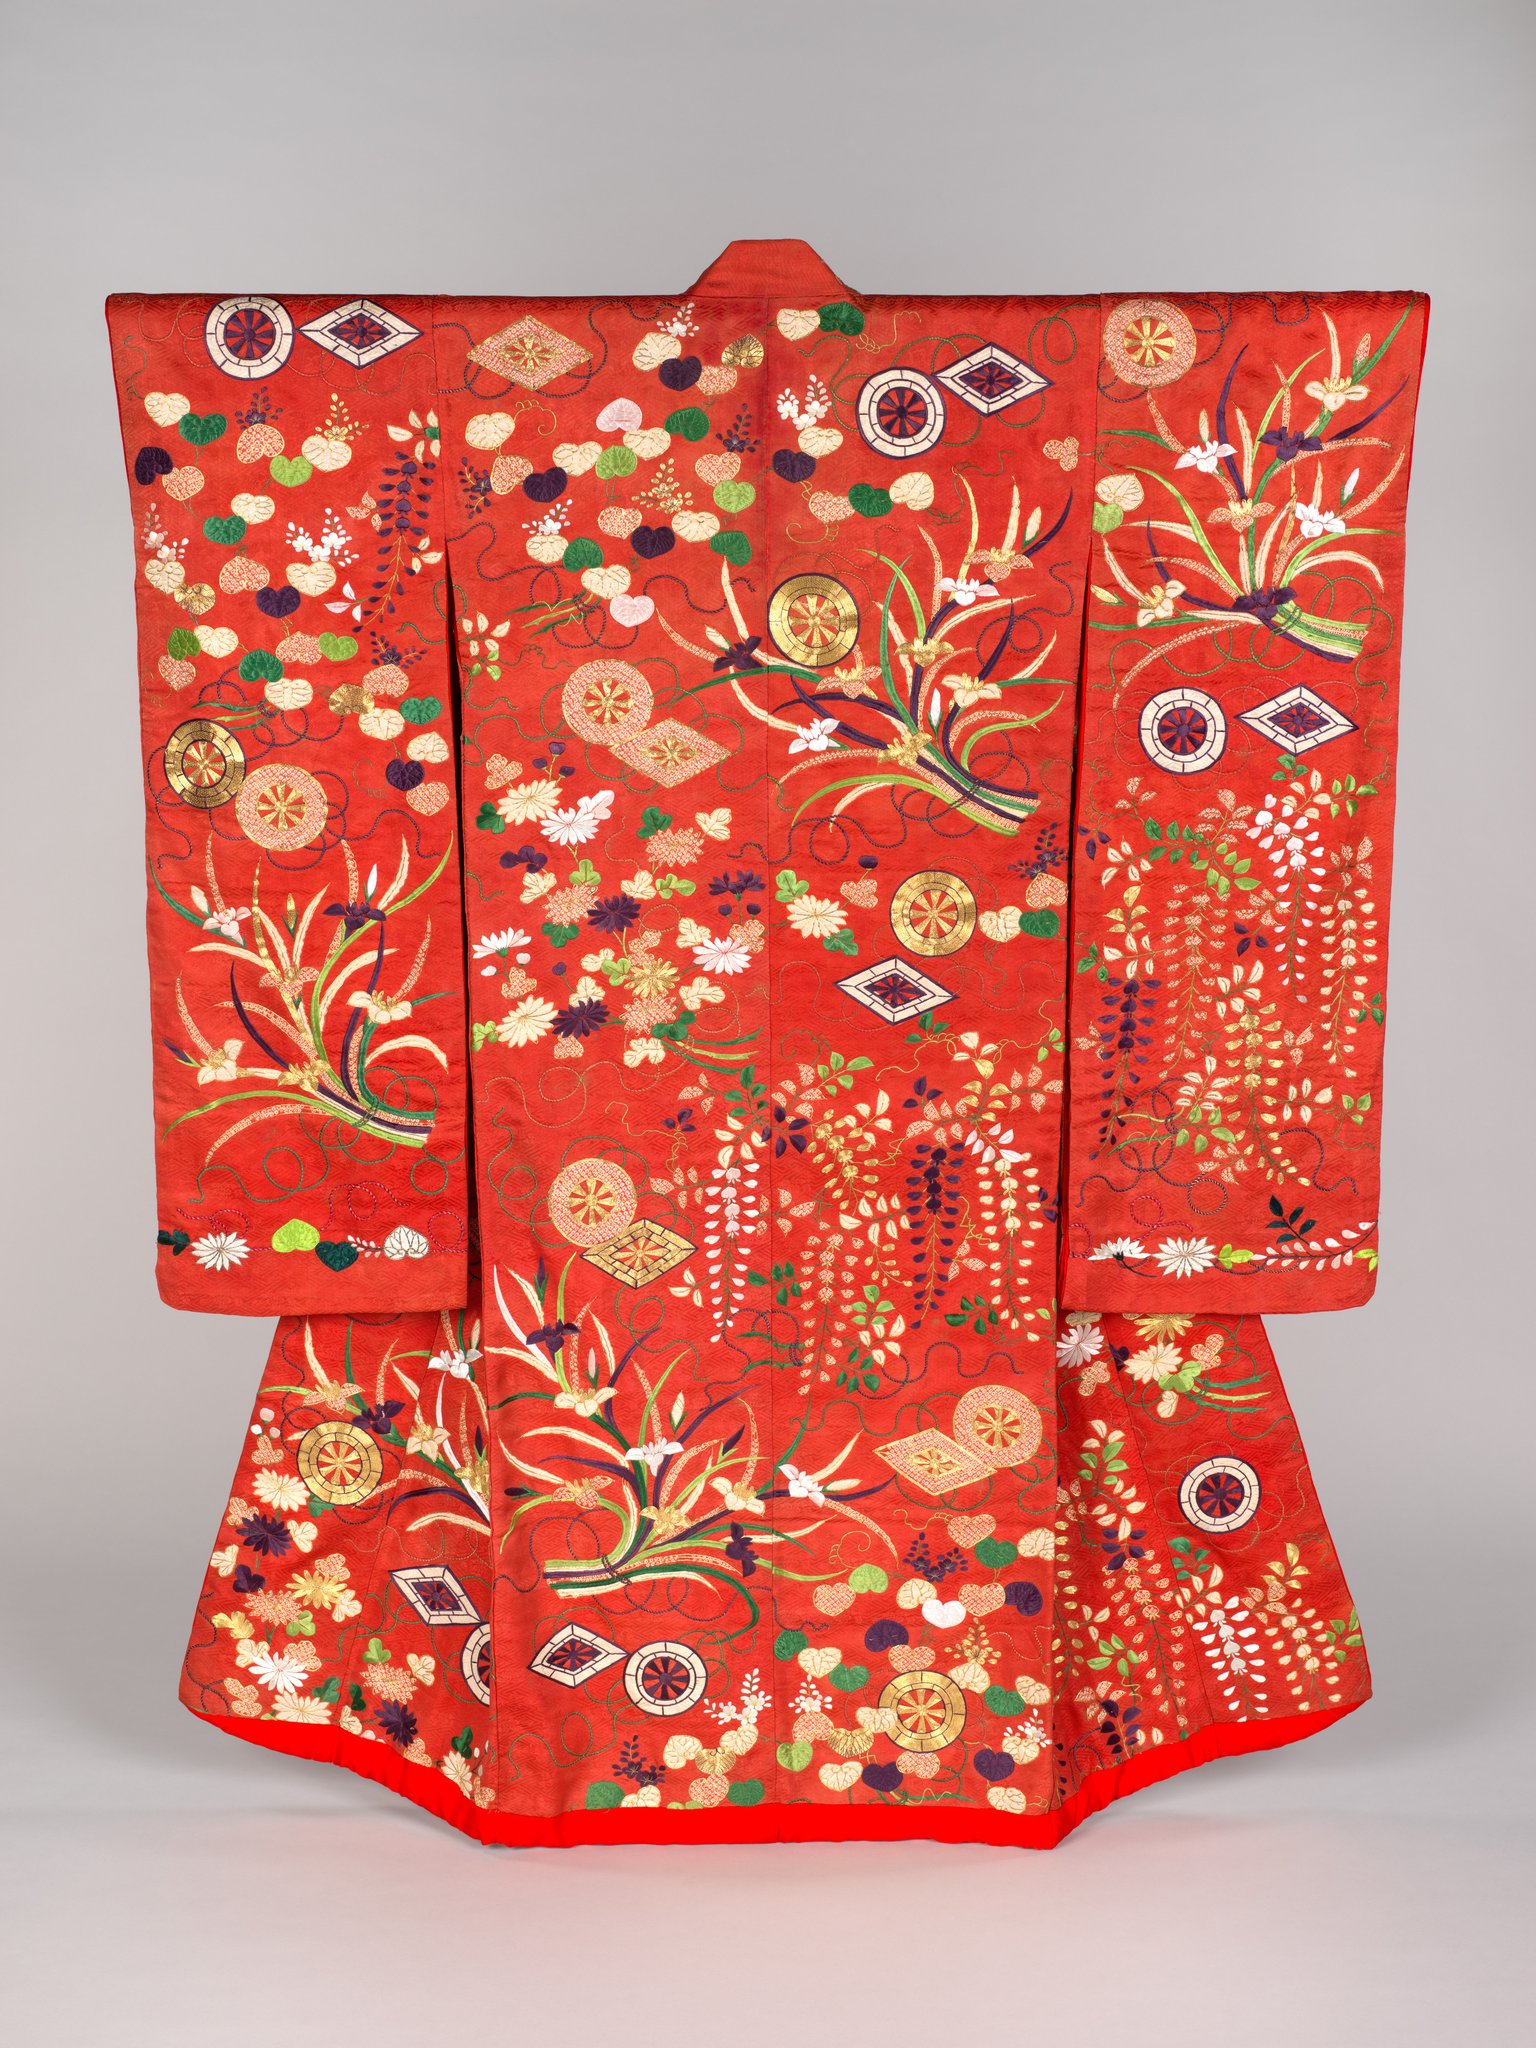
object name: kimono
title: Over robe (uchikake) with Genji wheels, narcissus bouquets, wild ginger leaves, wisteria, and chrysanthemums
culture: japanese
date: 1767-1800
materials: gold thread, silk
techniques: embroidery, satin weave